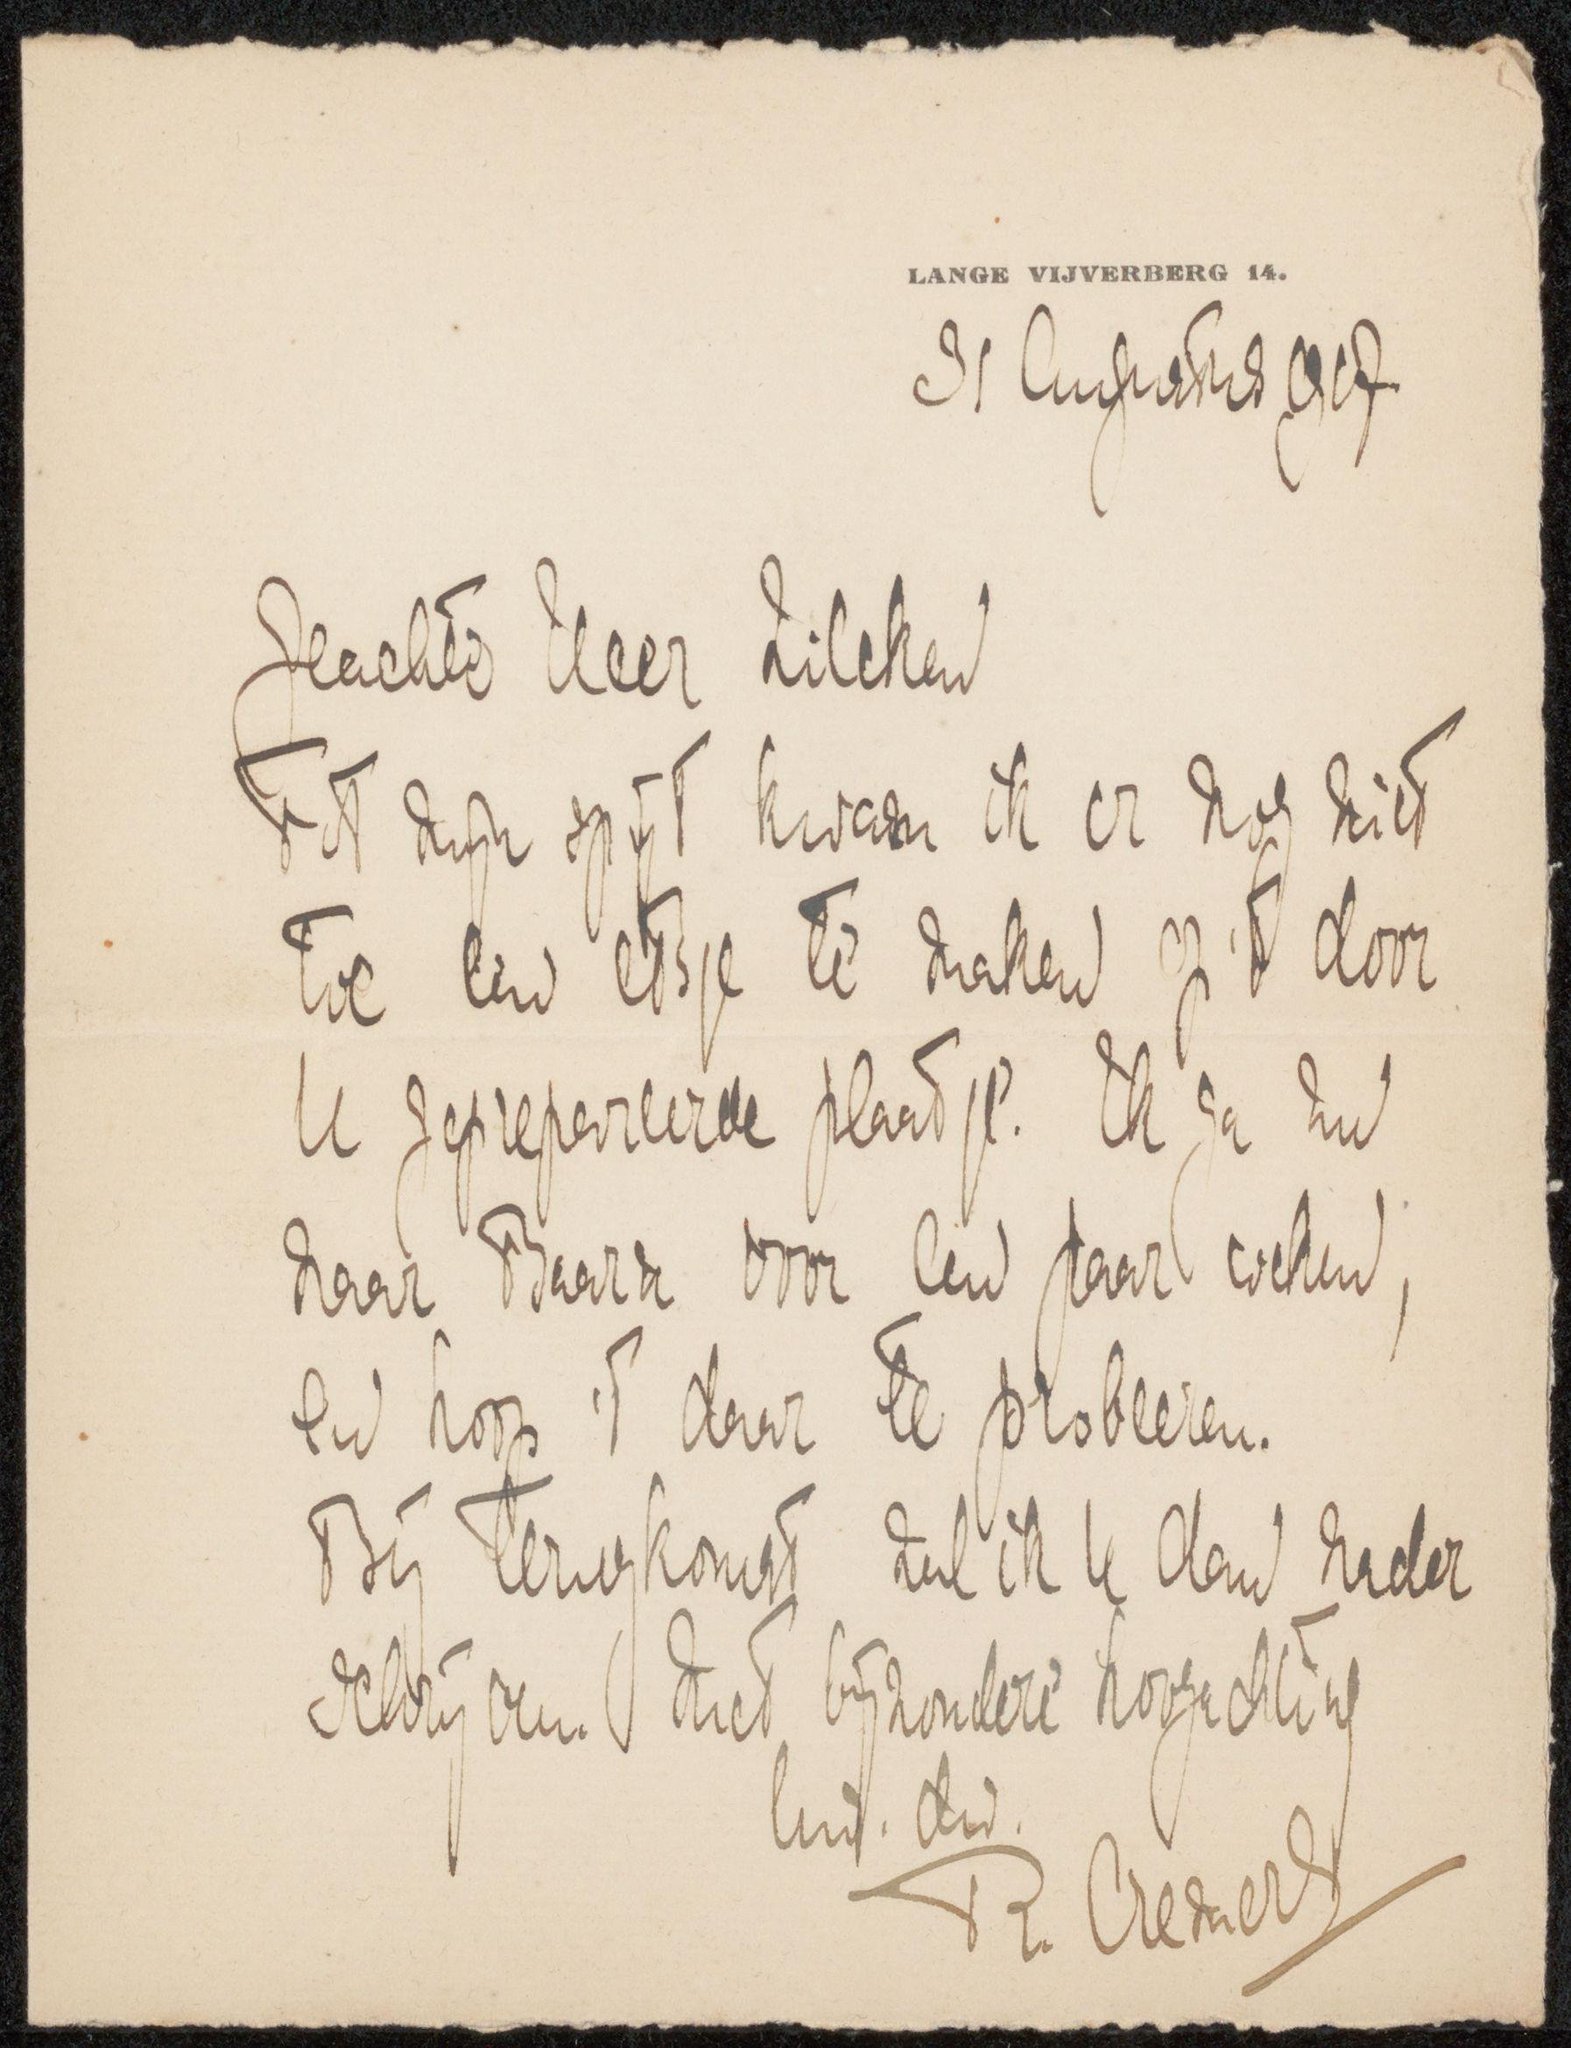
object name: letter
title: Brief aan Philip Zilcken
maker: r. cremers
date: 1907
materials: ink, paper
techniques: pen, printing, writing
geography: the hague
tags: painter, draughtsman, philip zilcken, etching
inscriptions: collector's mark: ‘RPK’, watermark